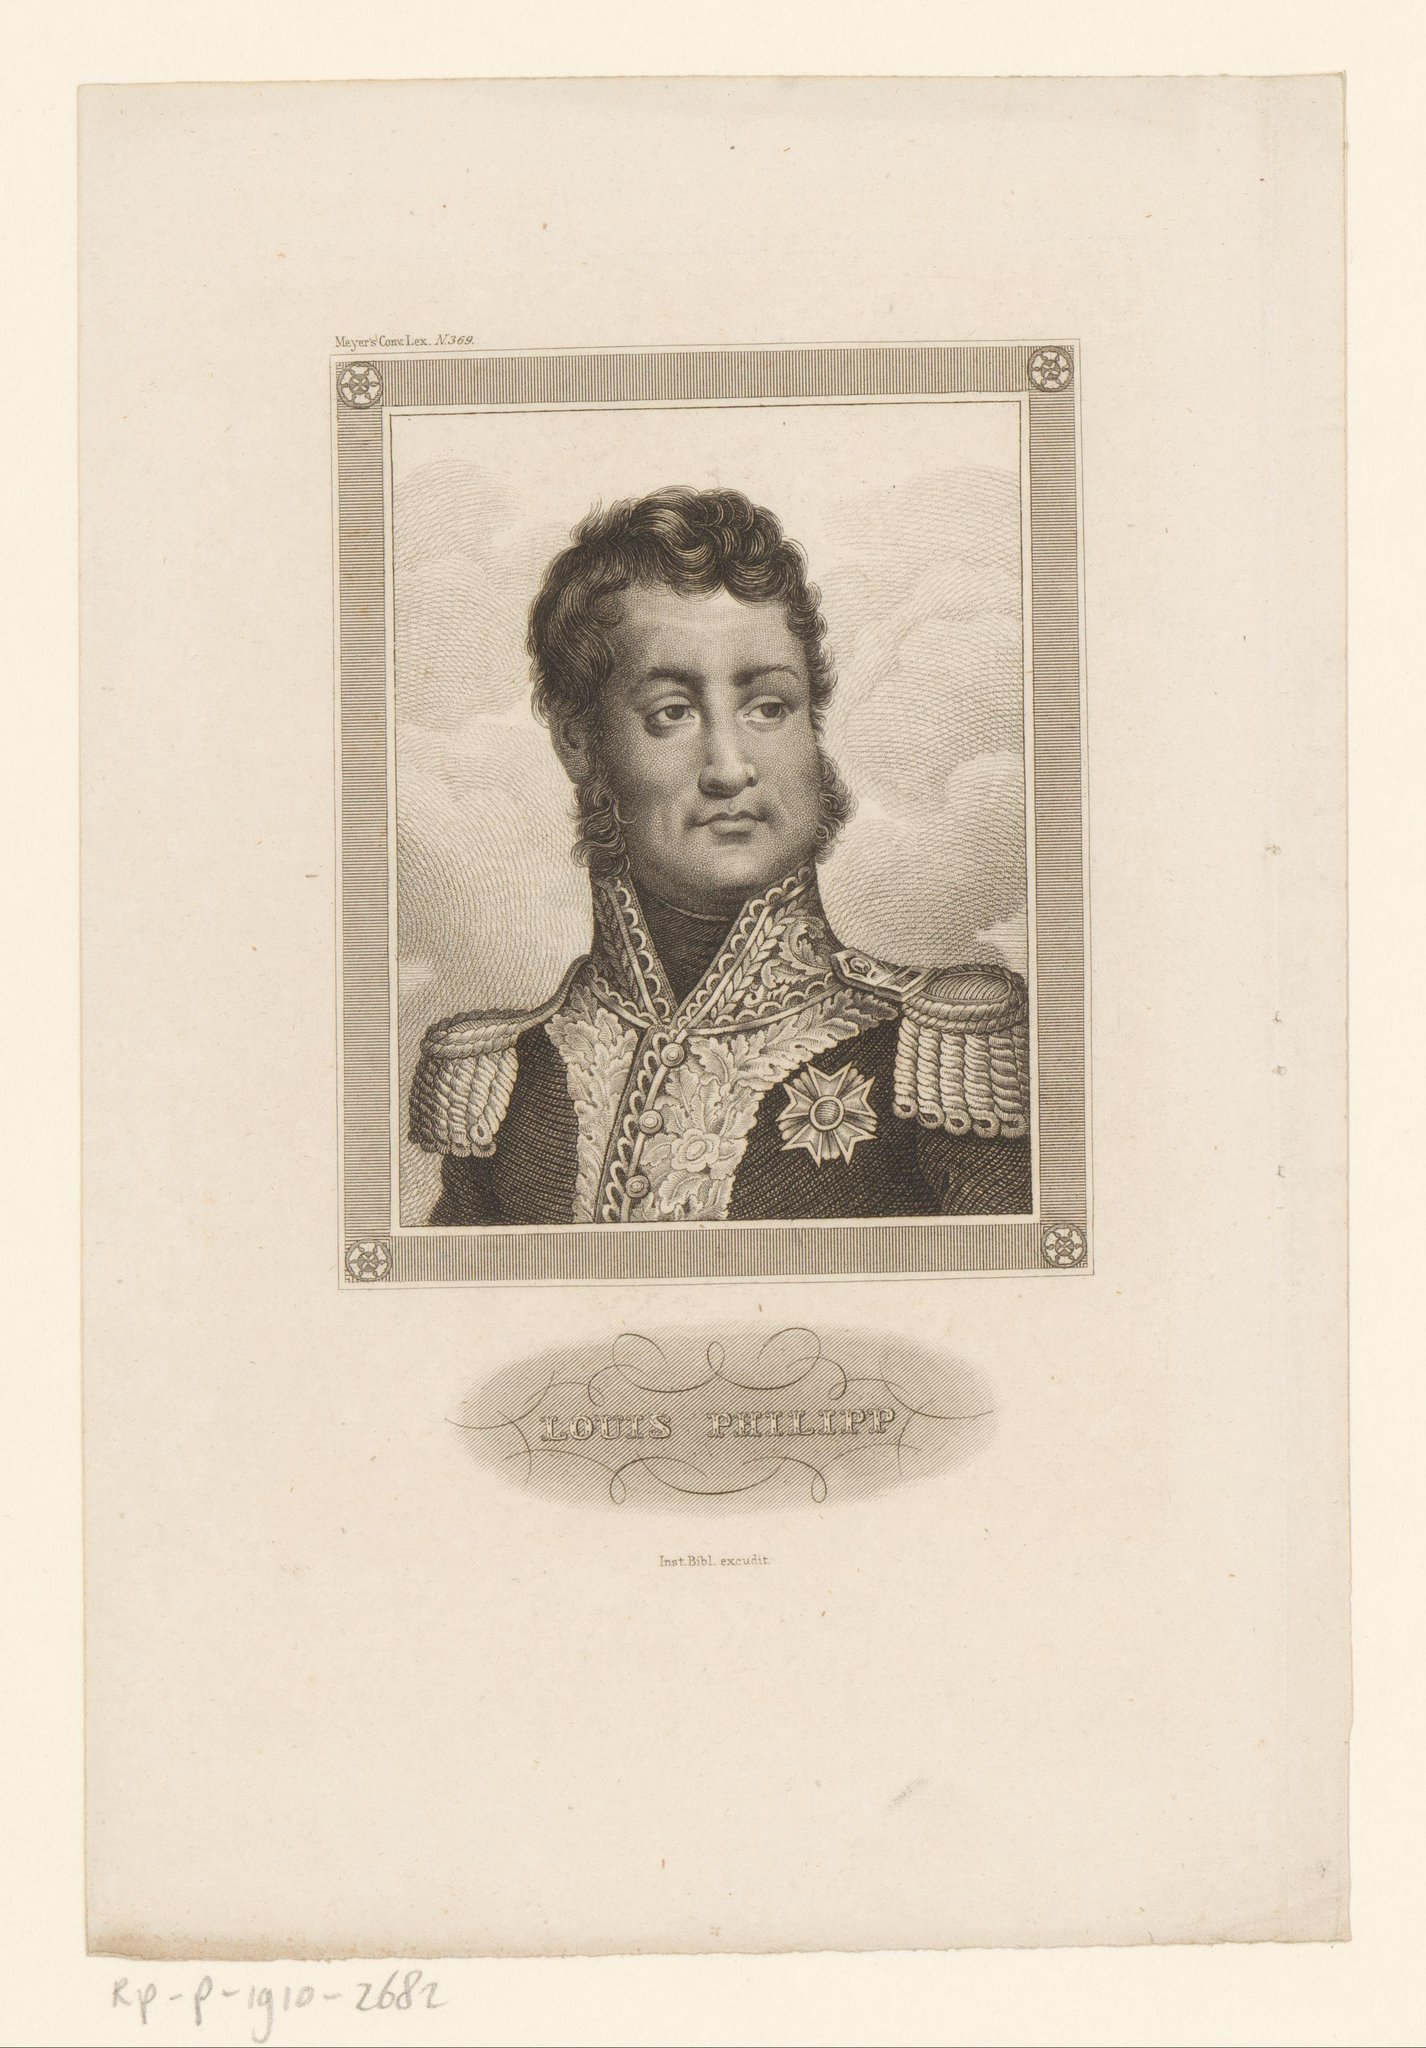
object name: print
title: Portret van Lodewijk Filips I, koning van Frankrijk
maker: johann georg nordheim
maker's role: print maker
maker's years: 1804-1853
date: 1840-1855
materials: paper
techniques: etching, engraving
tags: paris, lodewijk filips i (koning van frankrijk), historical persons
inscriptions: collector's mark: Lugt 2228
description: Prent afkomstig uit: Conversations-Lexikon für die gebildeten Stände, voor het eerst uitgegeven tussen 1840-1855.